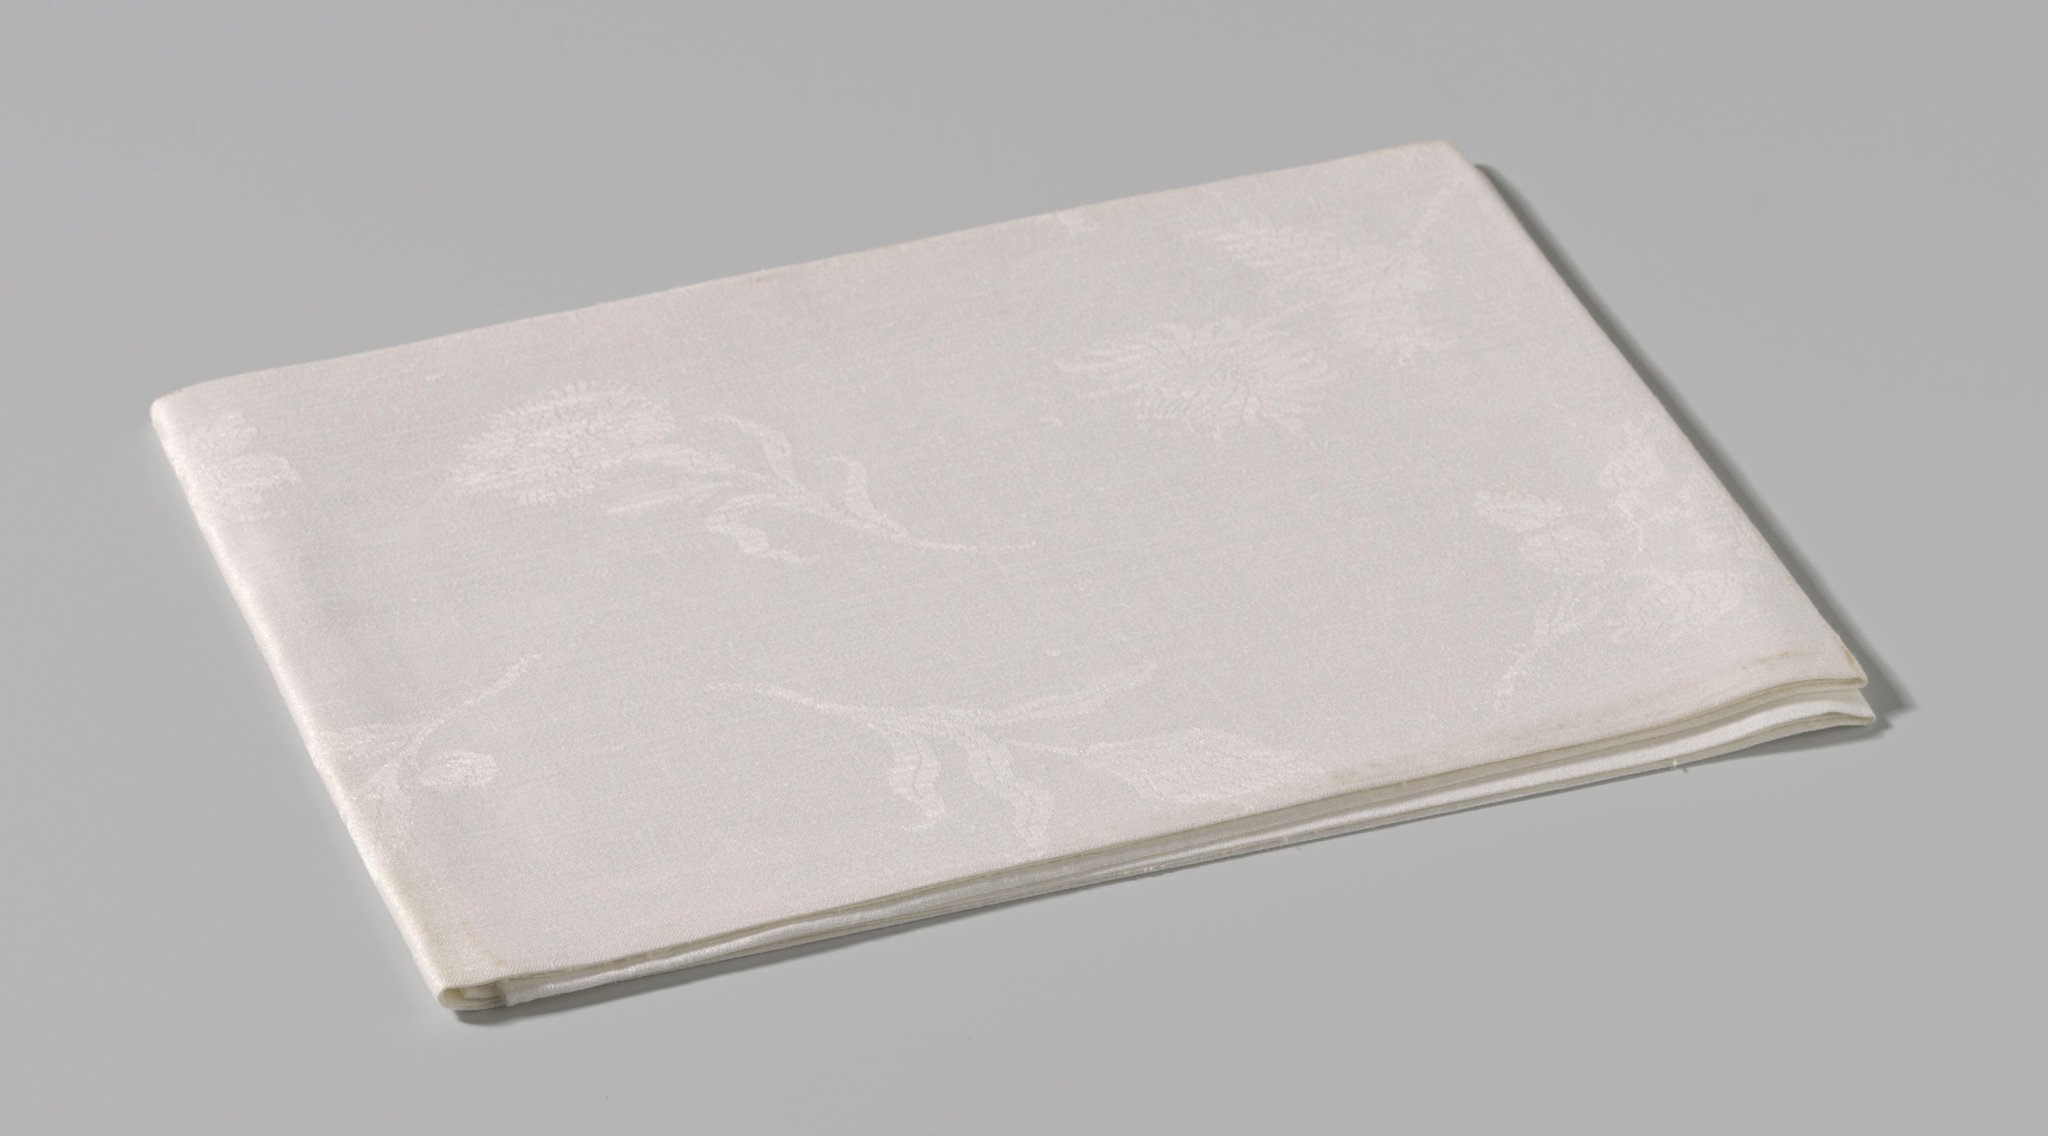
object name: napkin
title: Servet met een bloempatroon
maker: Anonymous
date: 1750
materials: linen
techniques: damask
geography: dresden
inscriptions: mark: ‘B’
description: Servet van linnendamast met een bloempatroon. Onder andere: roos, ranonkel, lelietje van dalen, anjer, tulp; met stelen die schuin en in rijen tegengesteld gericht zijn. Staande rand: dunne lopende voluutranken, waaraan onder andere kelkbloemen, papaver, chrysant, akelei, en wordt begrensd door grote asymmetrische rocaillemotieven, die op de hoeken naar het midden zijn gericht. Rondom: blokkenrand.